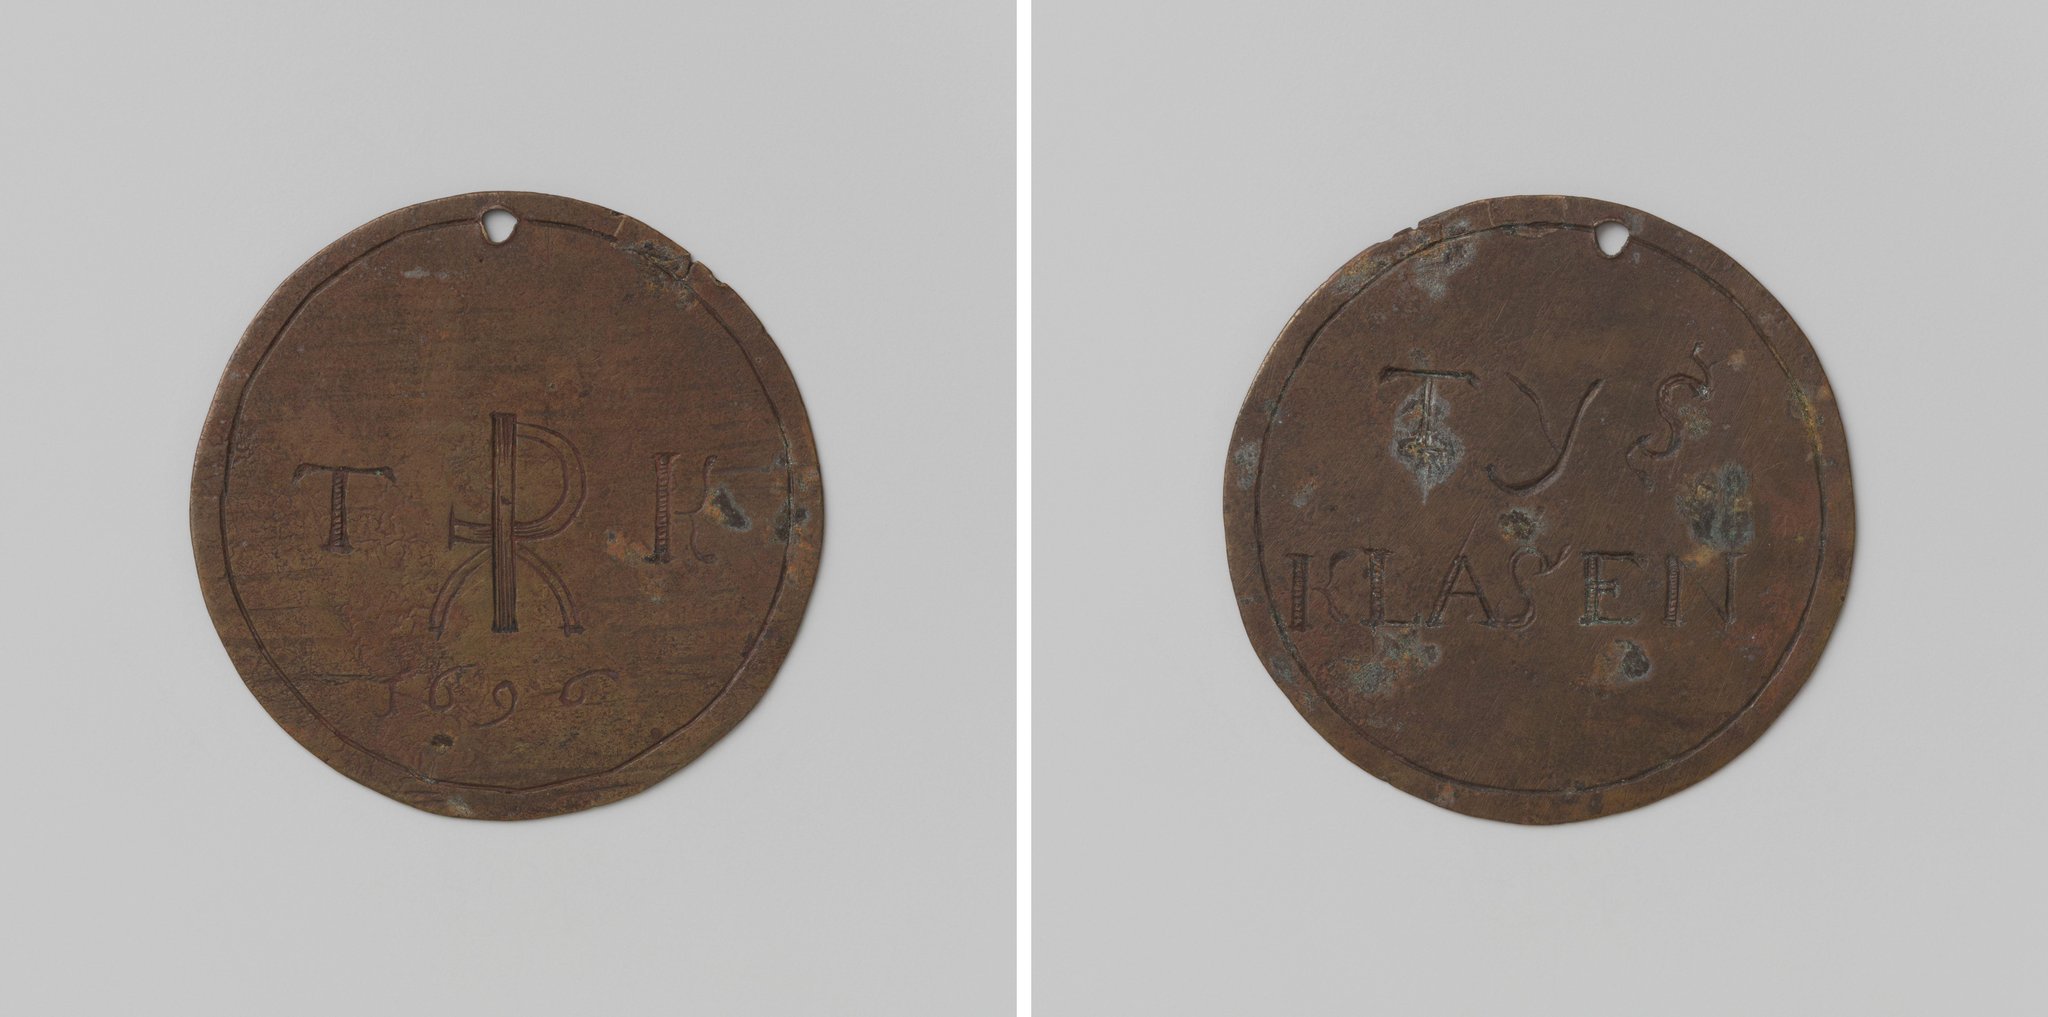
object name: medal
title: Onbekend gilde, gildepenning van Tijs Klasen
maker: Anonymous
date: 1696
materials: brass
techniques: engraving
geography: netherlands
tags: tijs klasen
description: Messing penning. Voorzijde: huismerk tussen letters T en K boven jaartal. Keerzijde: opschrift